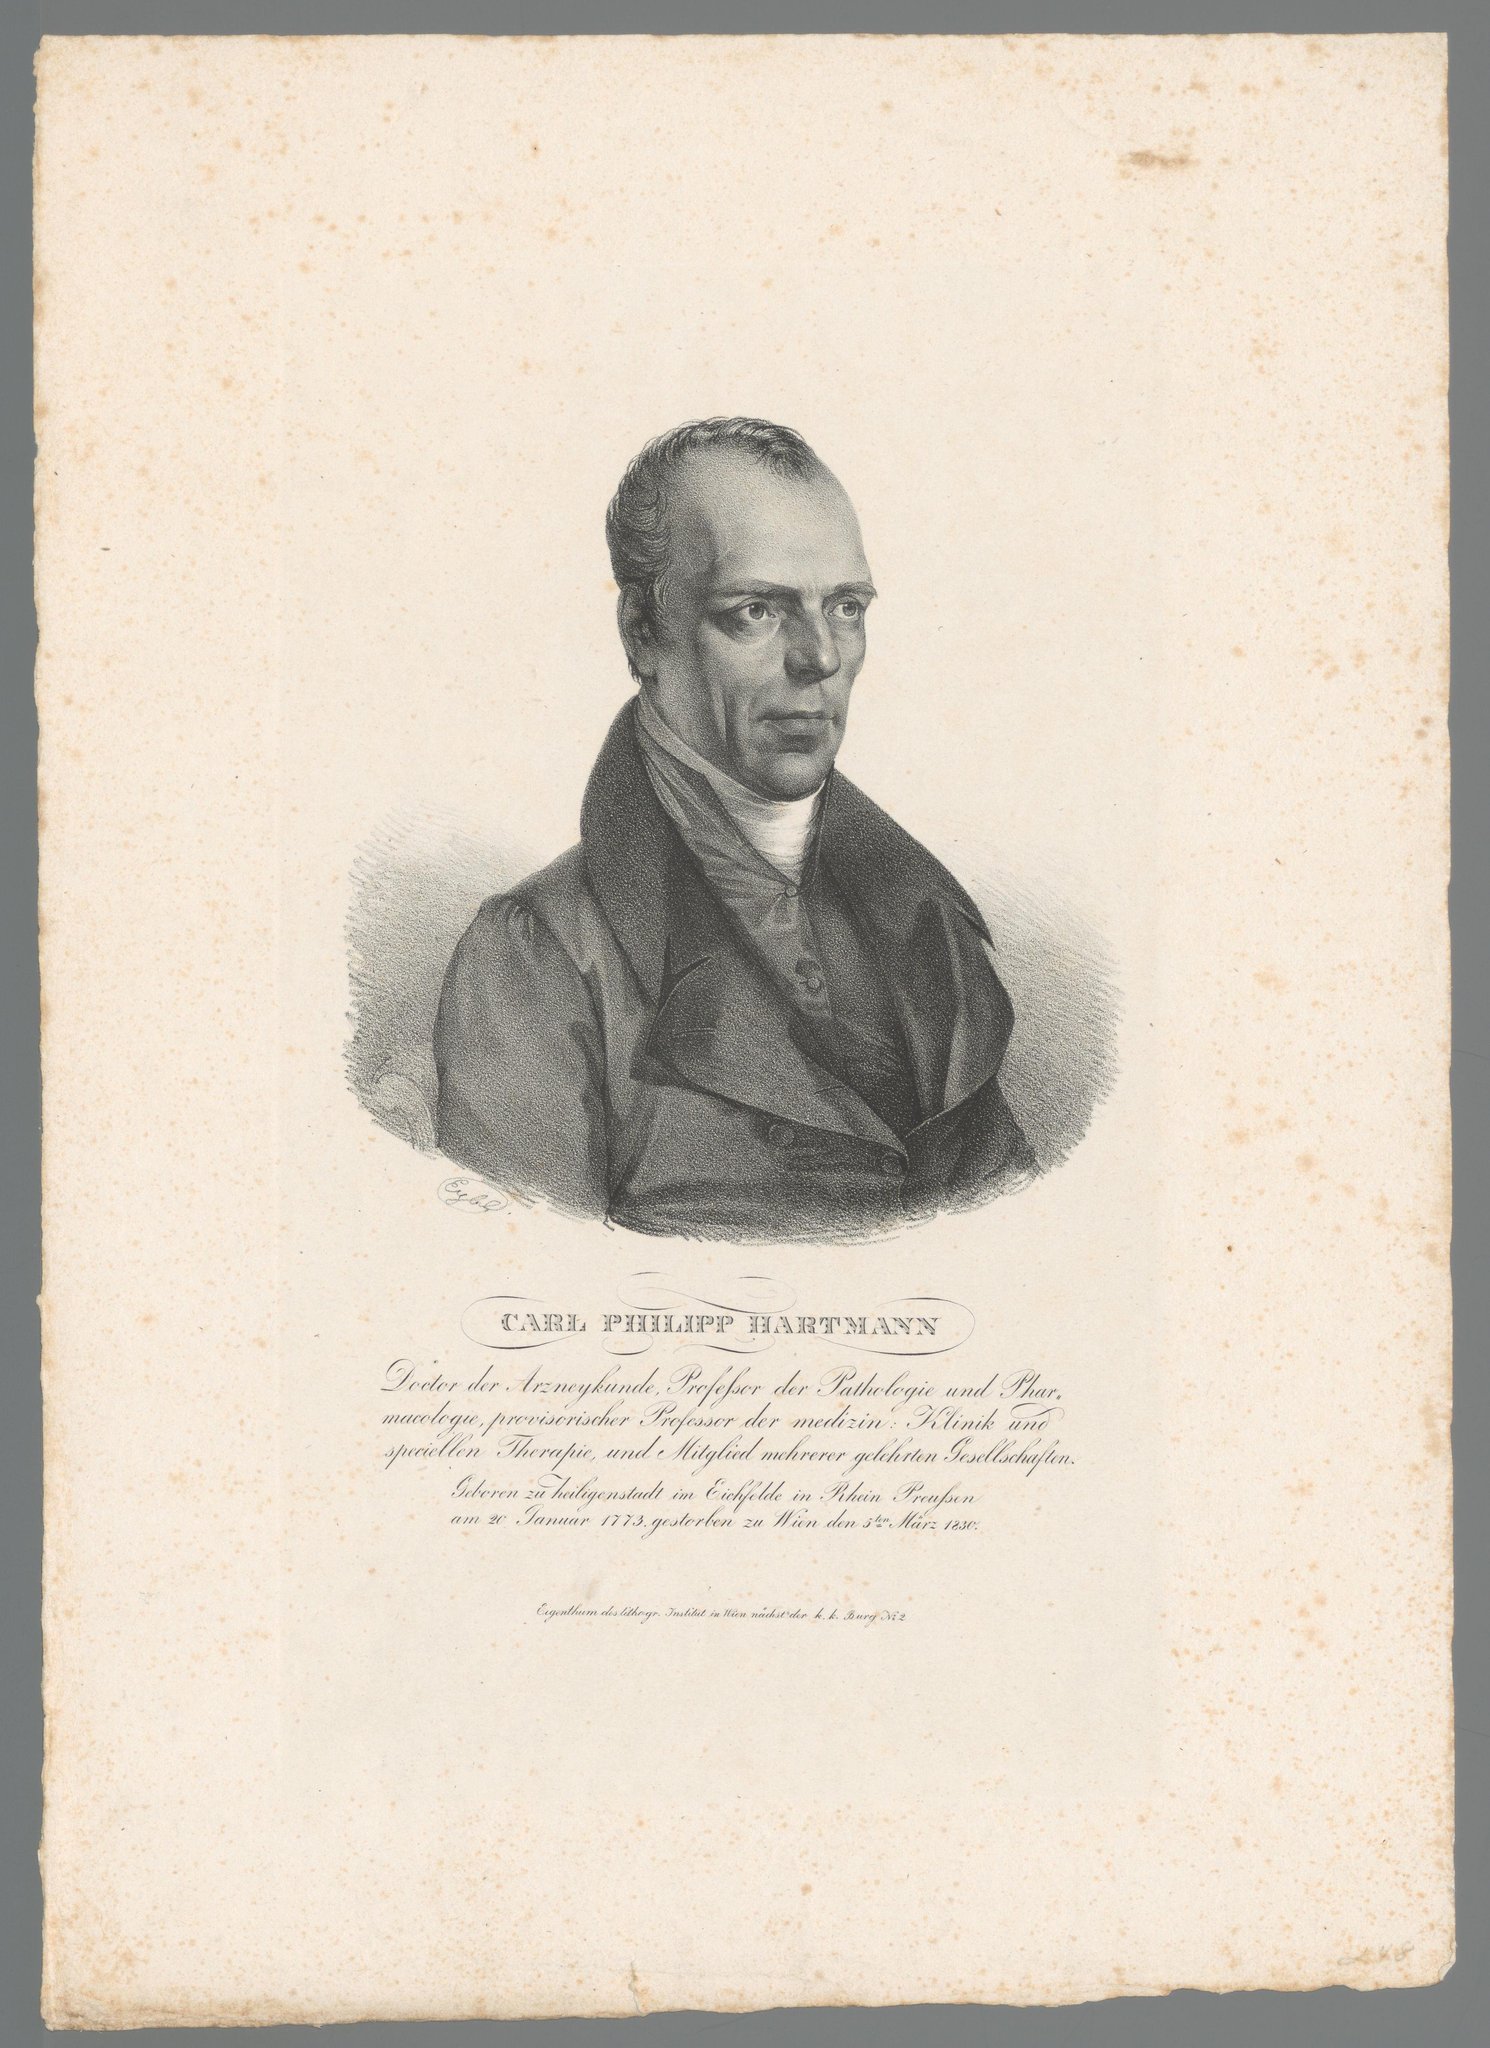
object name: print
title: Portret van Philipp Karl Hartmann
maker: franz eybl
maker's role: print maker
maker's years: 1806-1880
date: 1830-1880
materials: paper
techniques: lithograph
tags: historical persons, physician, doctor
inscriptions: collector's mark: Lugt 2228